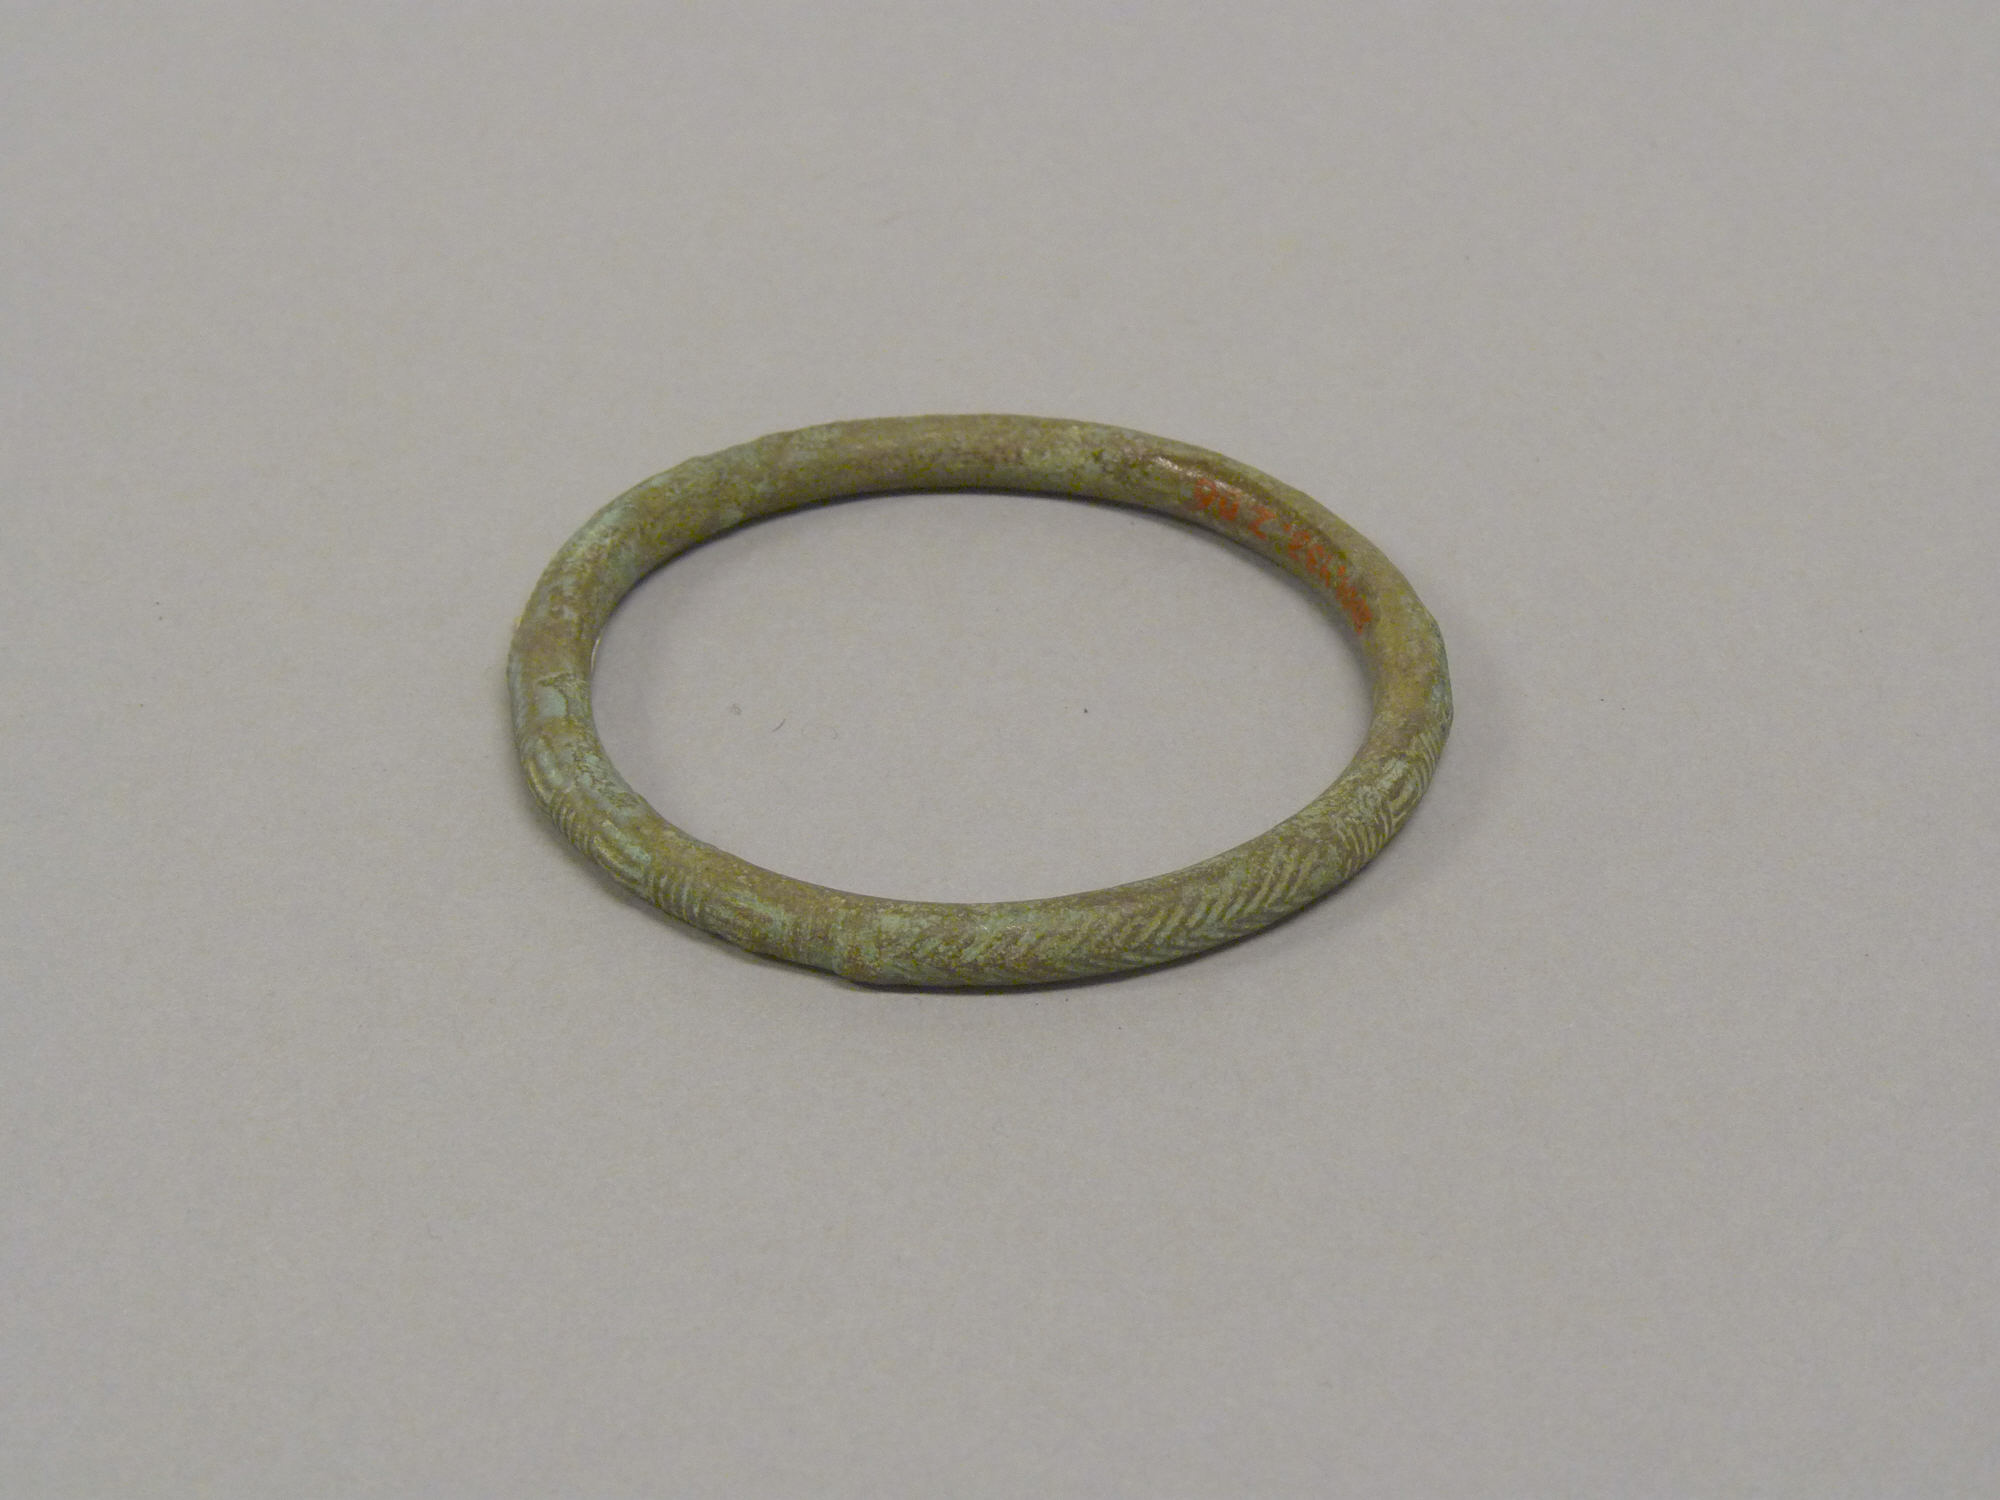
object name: bangle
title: Bangle with Circular Motifs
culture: thai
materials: bronze